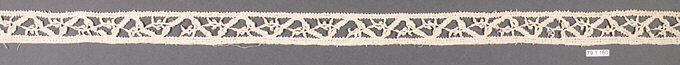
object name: insertion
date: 1600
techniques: lace